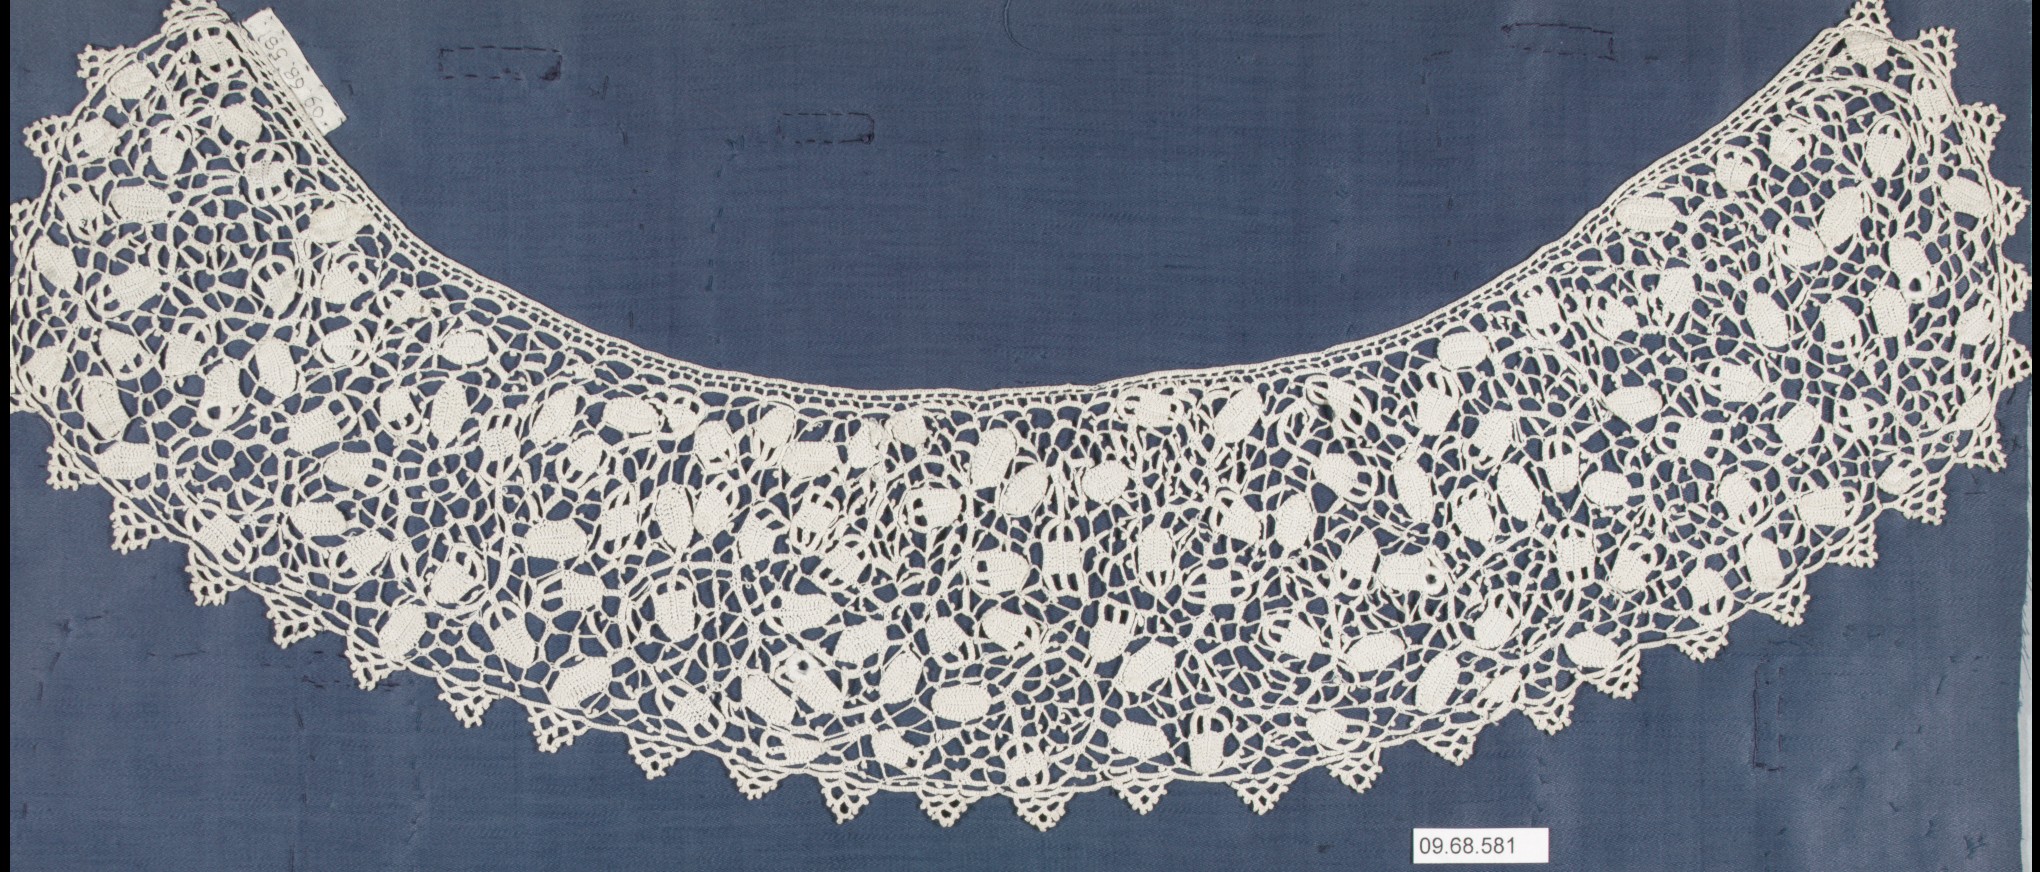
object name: collar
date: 1801-1900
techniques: crochet